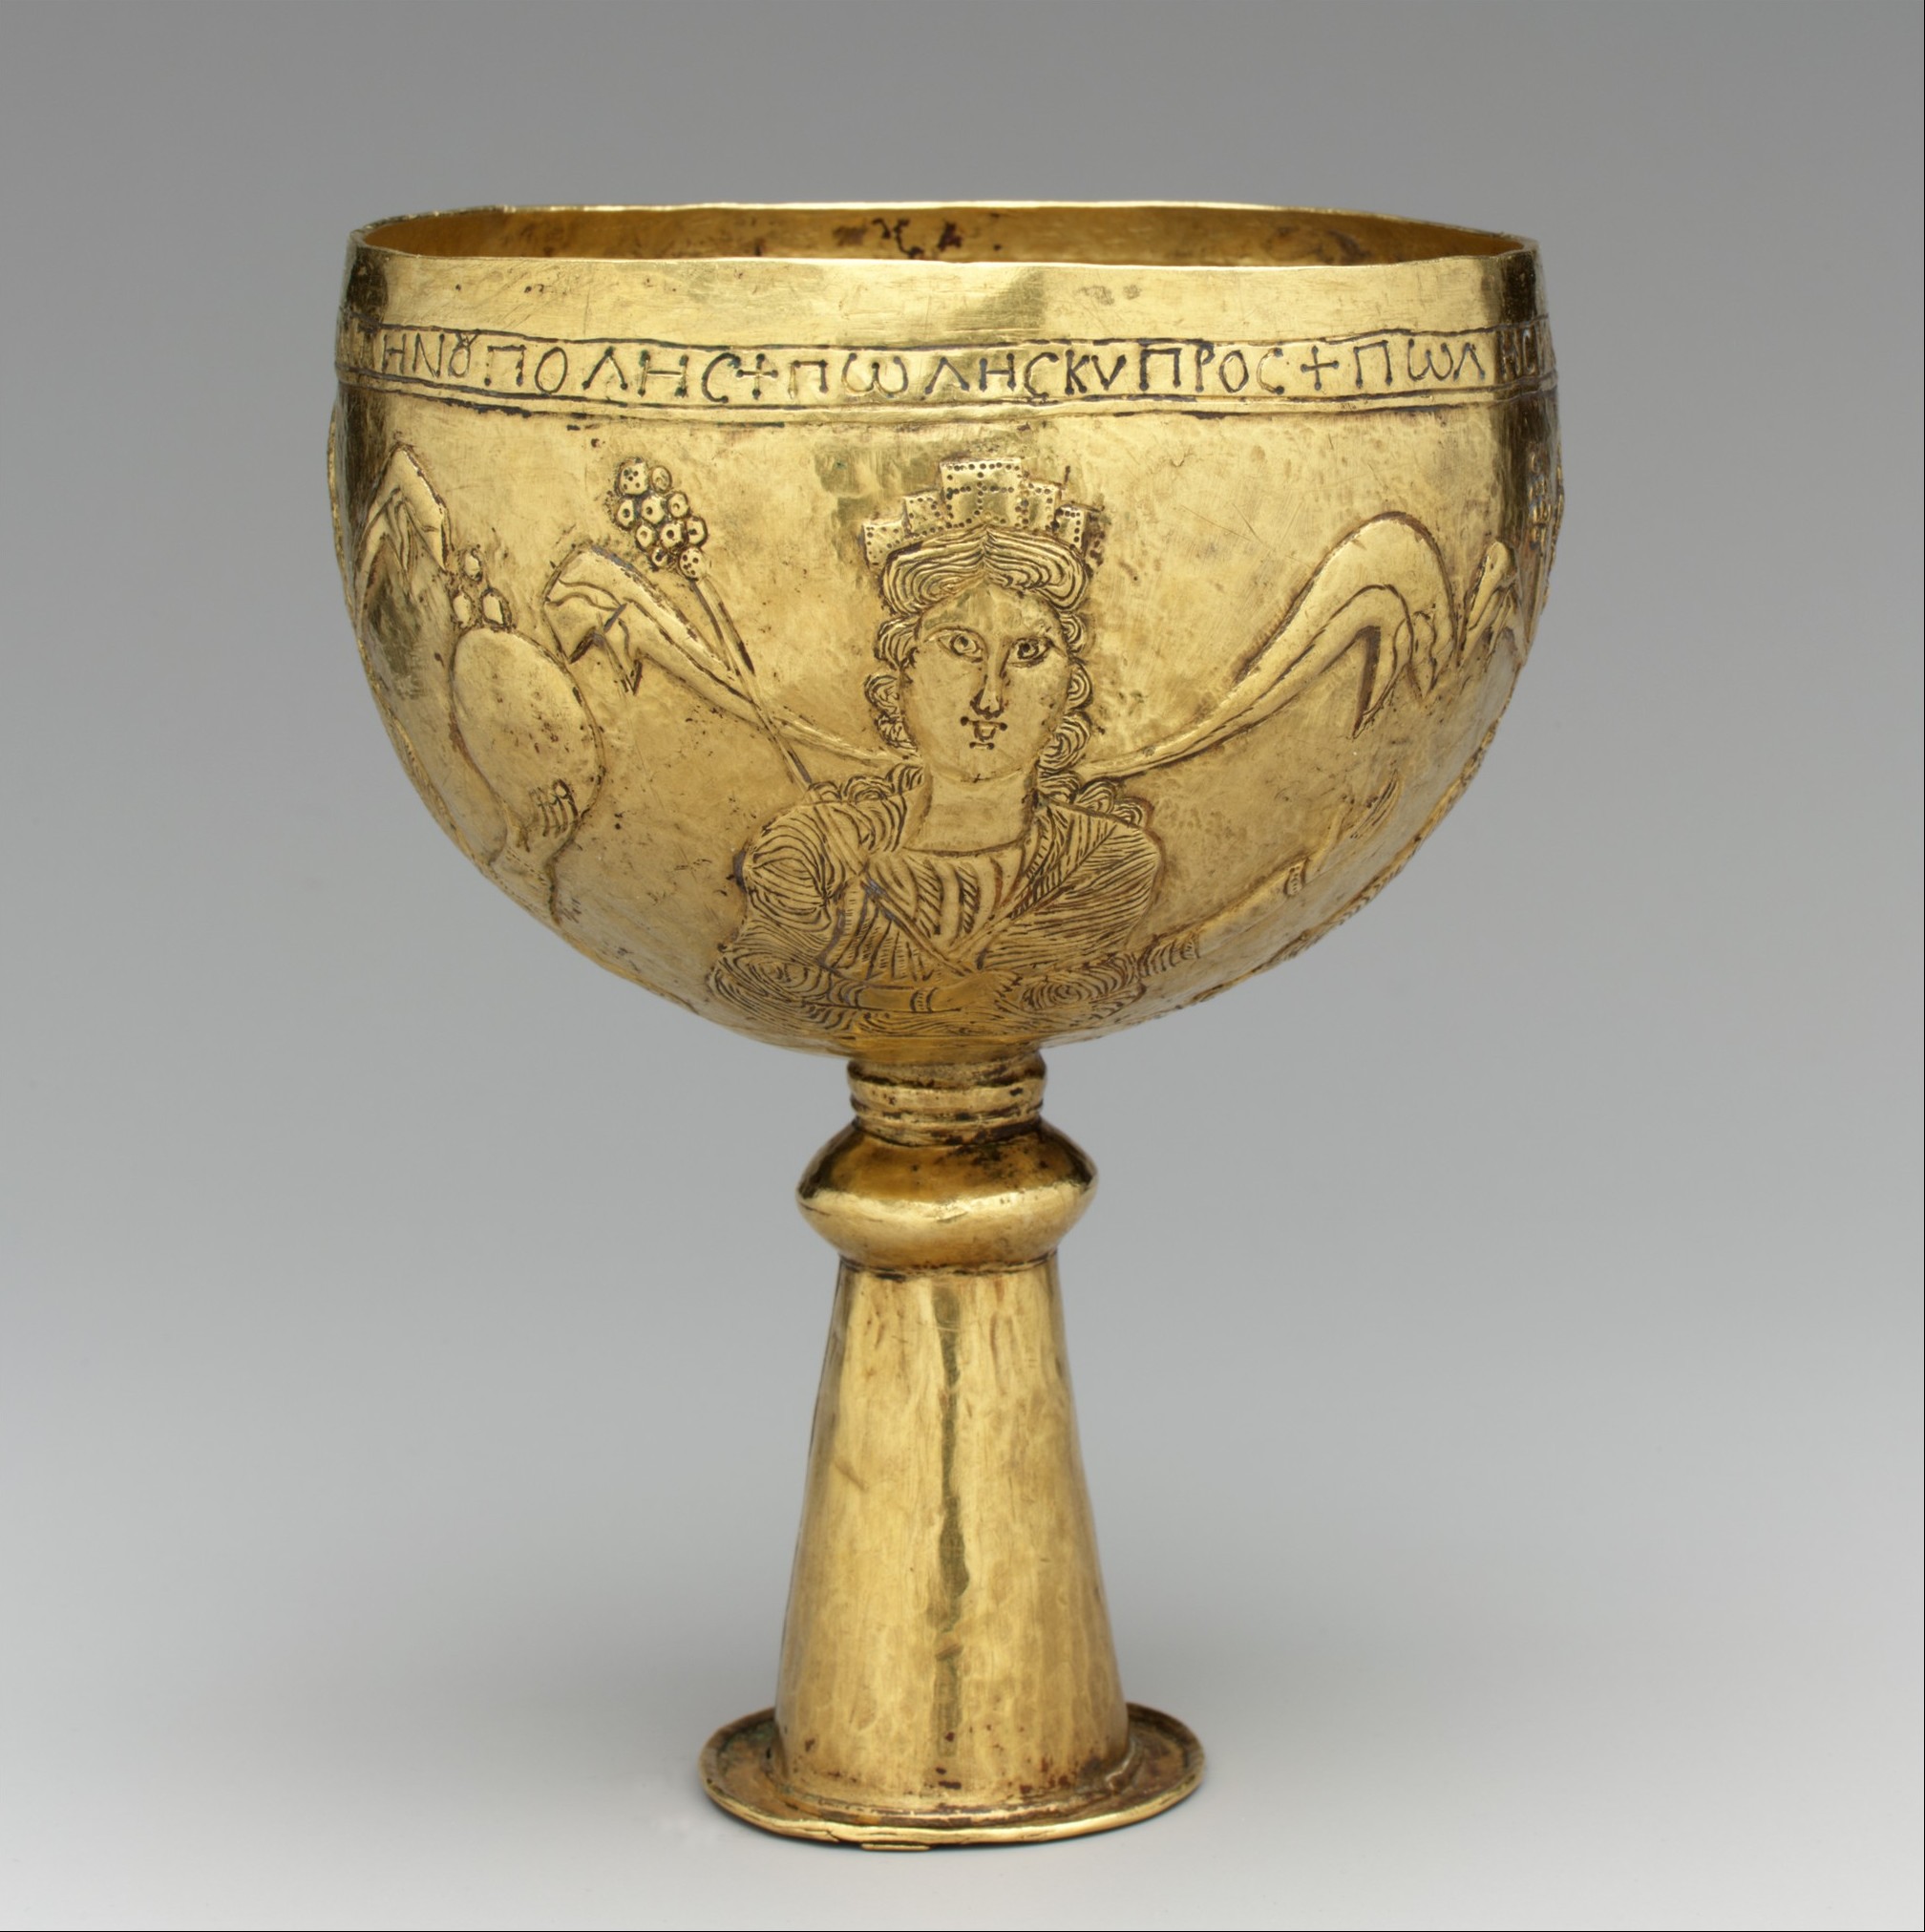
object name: chalice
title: Goblet with Personifications of Cyprus, Rome, Constantinople, and Alexandria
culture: avar or byzantine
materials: gold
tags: women